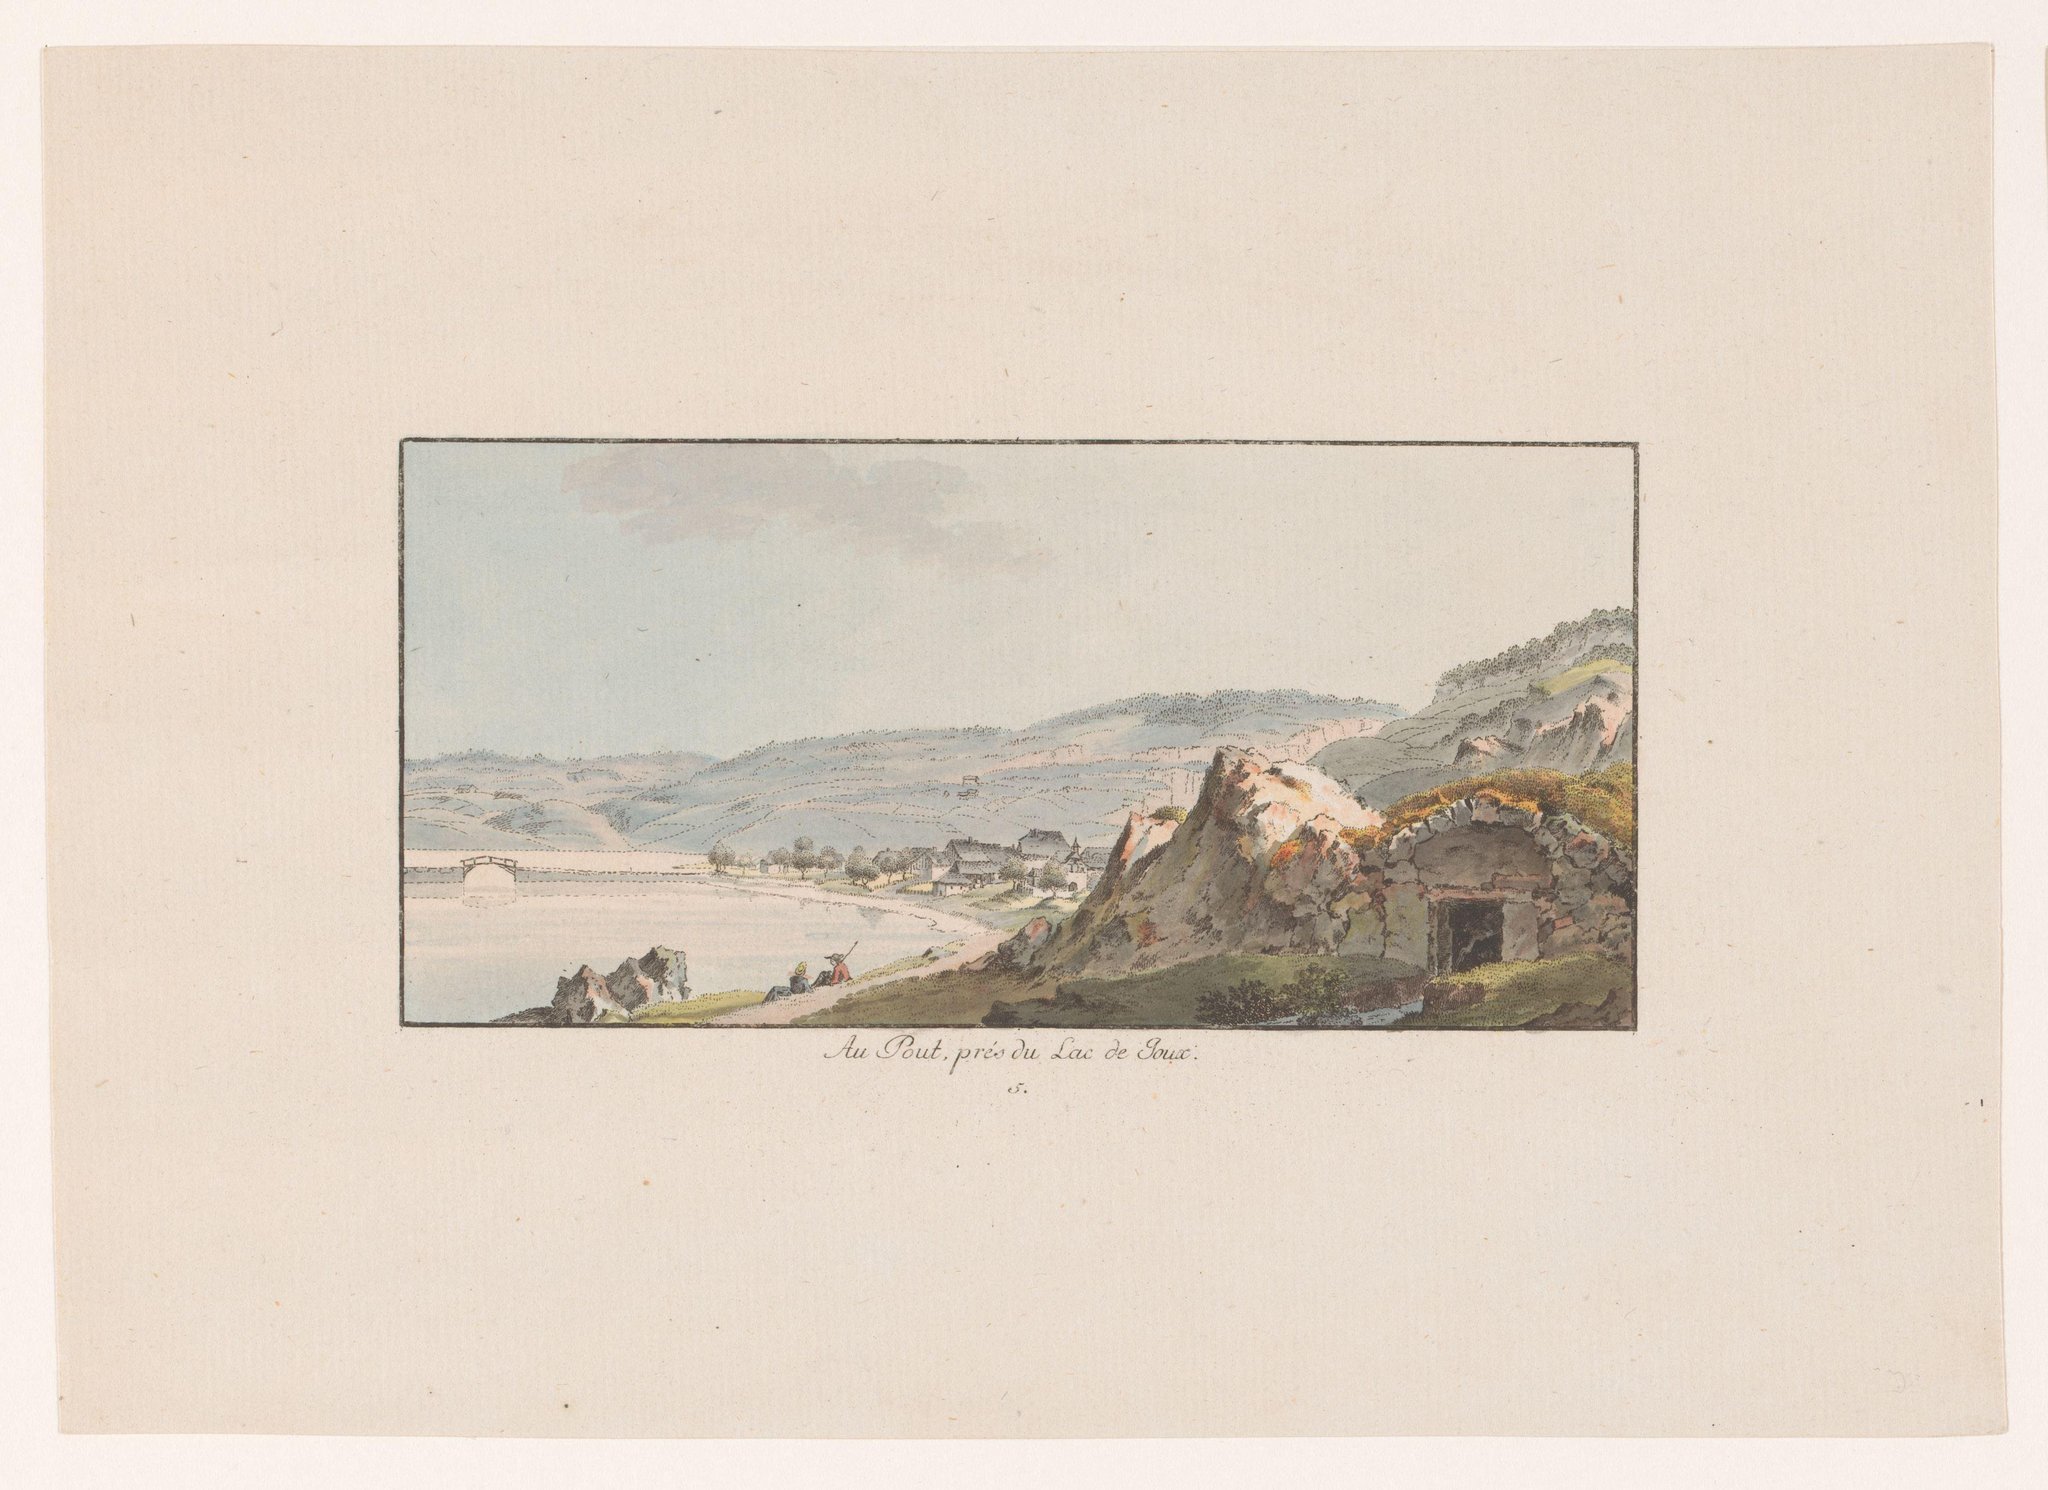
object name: print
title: Gezichten op Zwitserland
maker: johann ludwig aberli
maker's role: print maker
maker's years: 1723-1786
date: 1782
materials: paper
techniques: etching, hand coloring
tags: lake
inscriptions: watermark, collector's mark: Lugt 2228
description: Maakt deel uit van een serie met gezichten op Zwitserland.